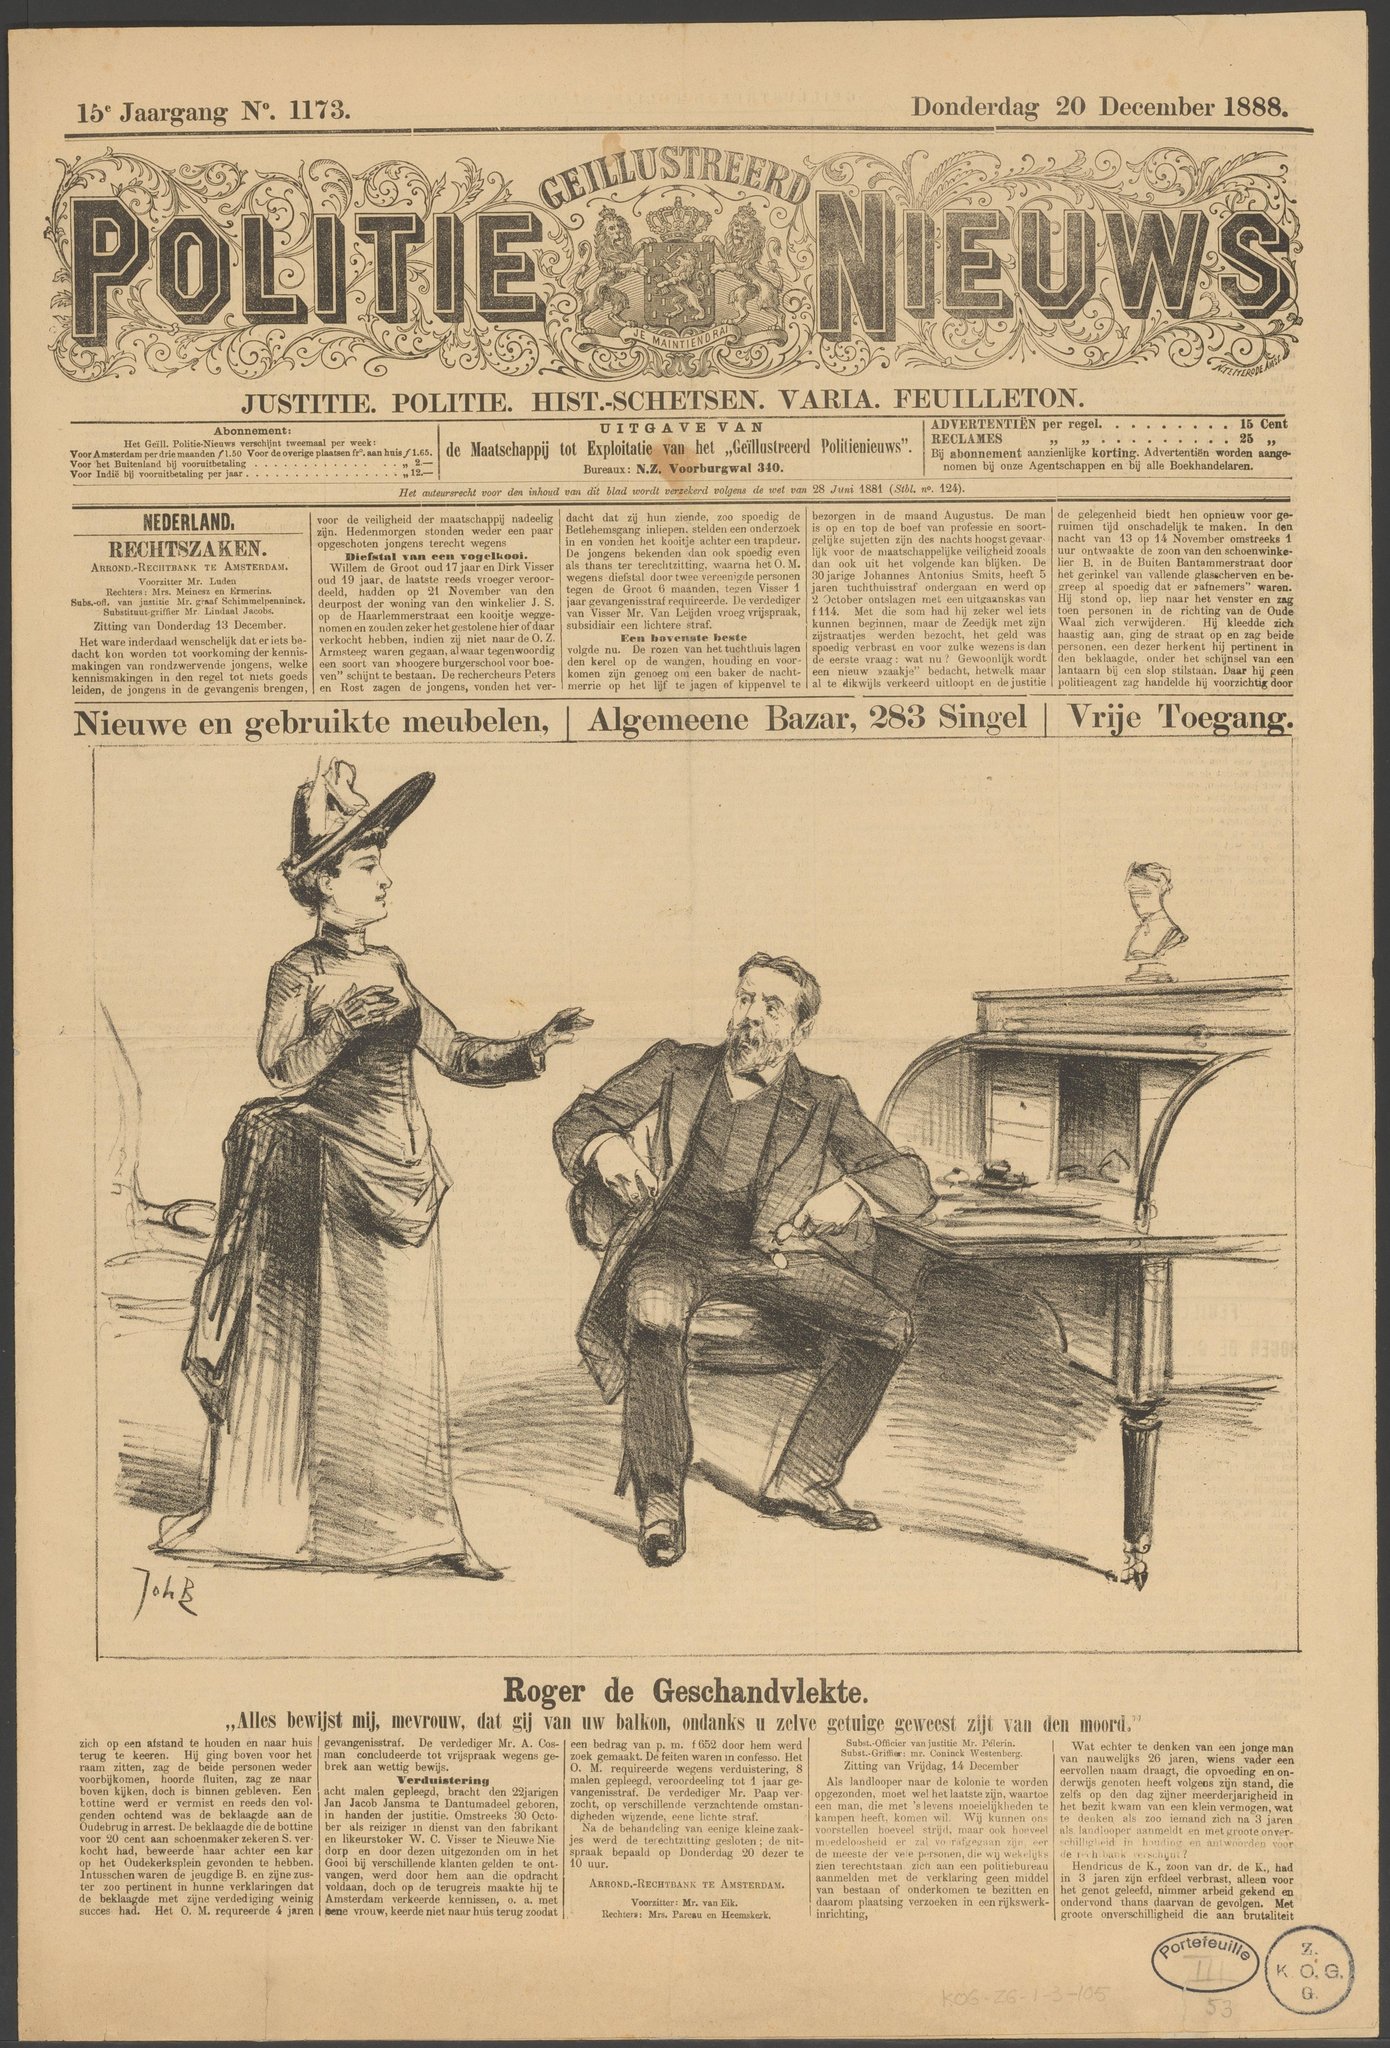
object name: newspaper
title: Geïllustreerd Politie Nieuws, 20 December 1888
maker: johan braakensiek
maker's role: draughtsman, print maker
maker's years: 1858-1940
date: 1888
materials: paper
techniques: letterpress printing, lithograph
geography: amsterdam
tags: standing figure (canon, proportions) - aa - female human figure, lawyer, attorney at law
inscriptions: collector's mark: Lugt 1641, stamp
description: Exemplaar van de krant 'Geïllustreerd Politienieuws' van 20 December 1888. Met op de voorpagina een illustratie van een scène uit Roger de Geschandvlekte. Twee bladen, alle zijden bedrukt. Onderwerpsrubrieken binnen de Atlas Zeden en Gewoonten: Regeering, Rechtsweezen.